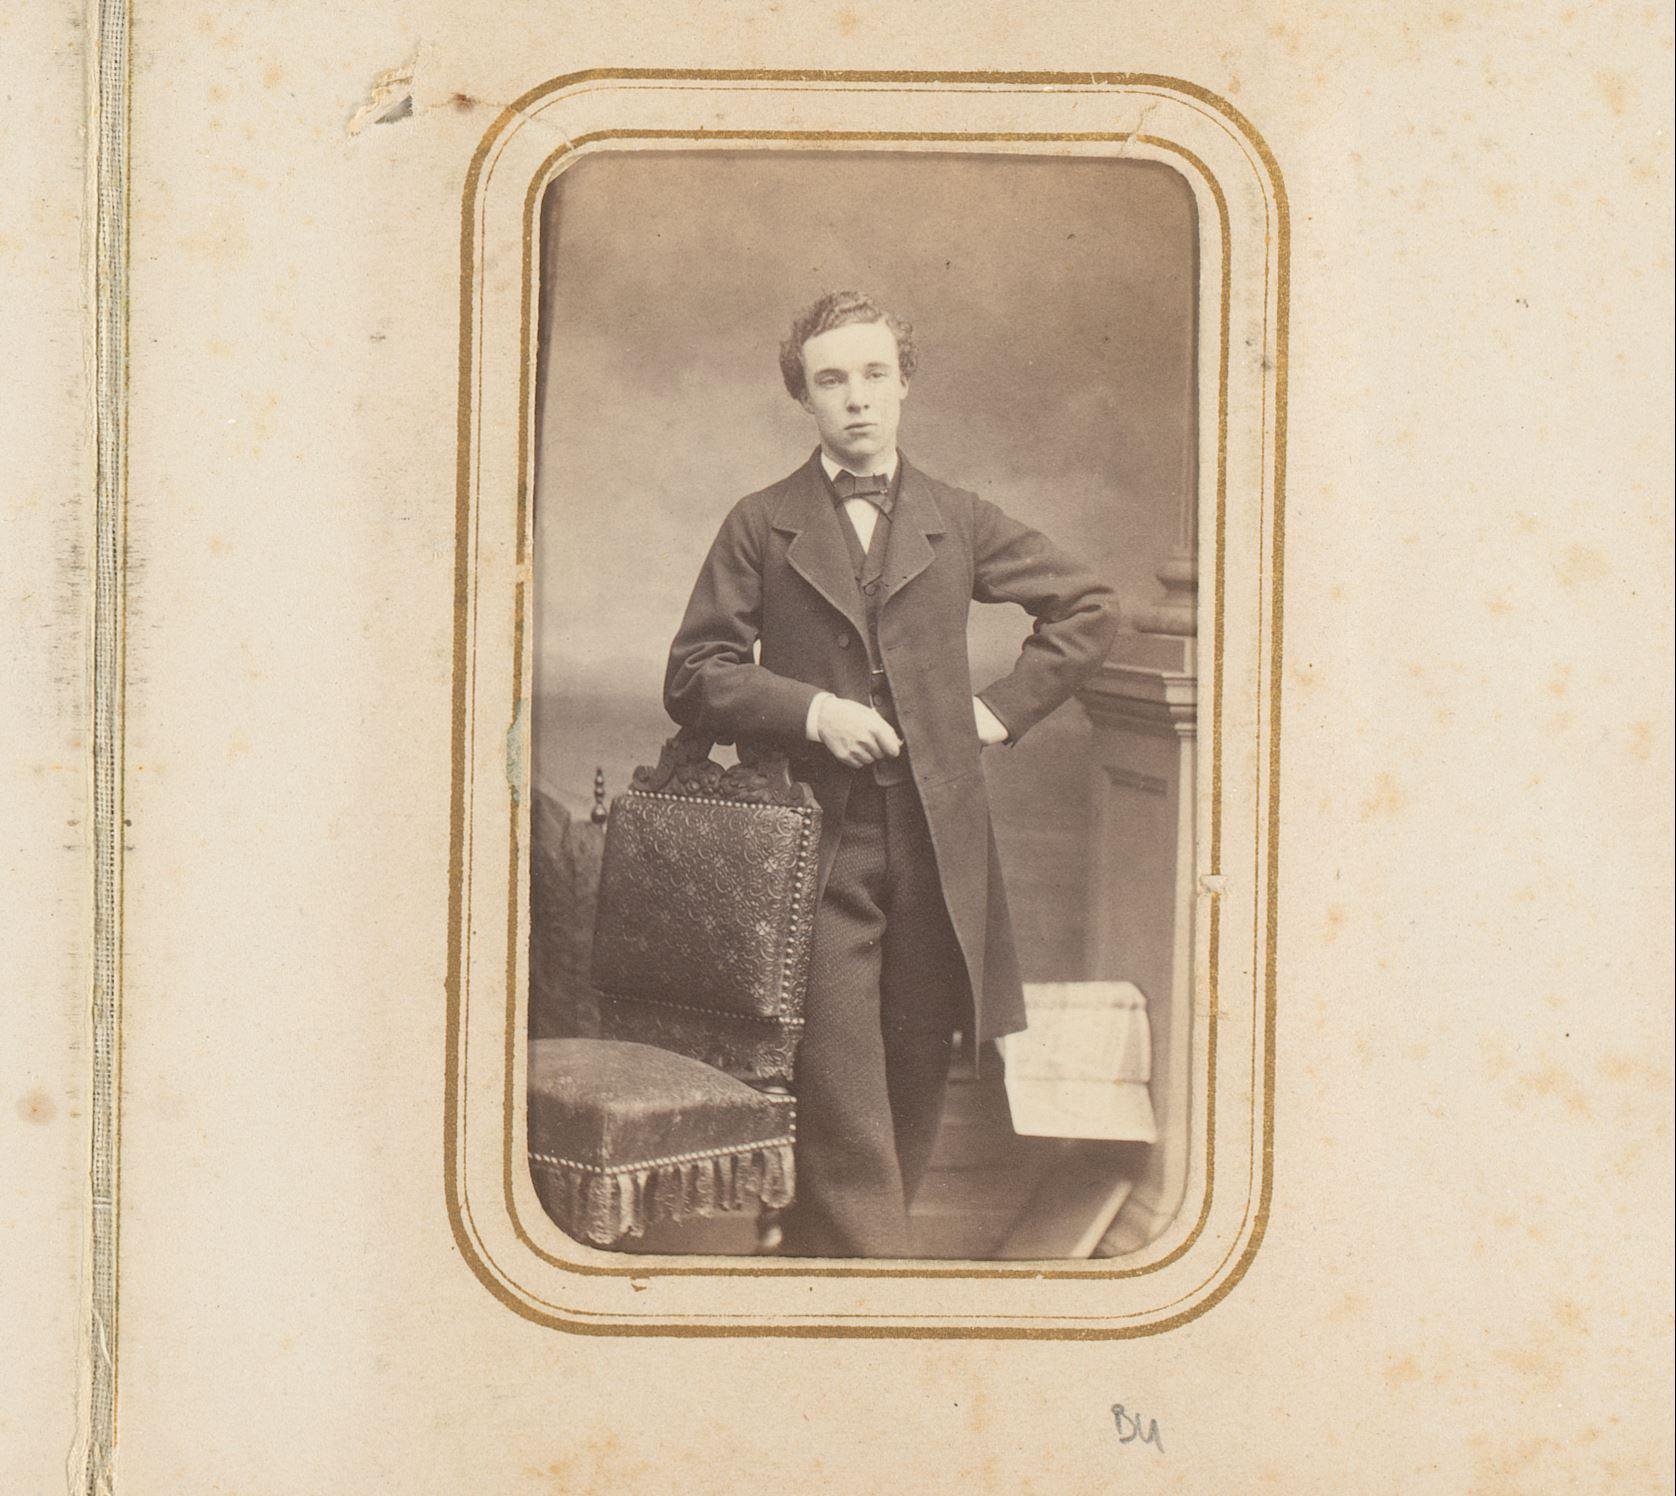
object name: album leaf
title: Portret van een jongeman, staand bij een stoel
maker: louis wegner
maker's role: print maker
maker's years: 1816-1864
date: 1857-1864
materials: cardboard, photographic support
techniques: albumen print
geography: amsterdam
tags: historical persons, youth, adolescent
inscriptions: inscription: ‘Photogr. Atelier/ L. Wegner/ Prinsengracht BB 439/ Amsterdam’